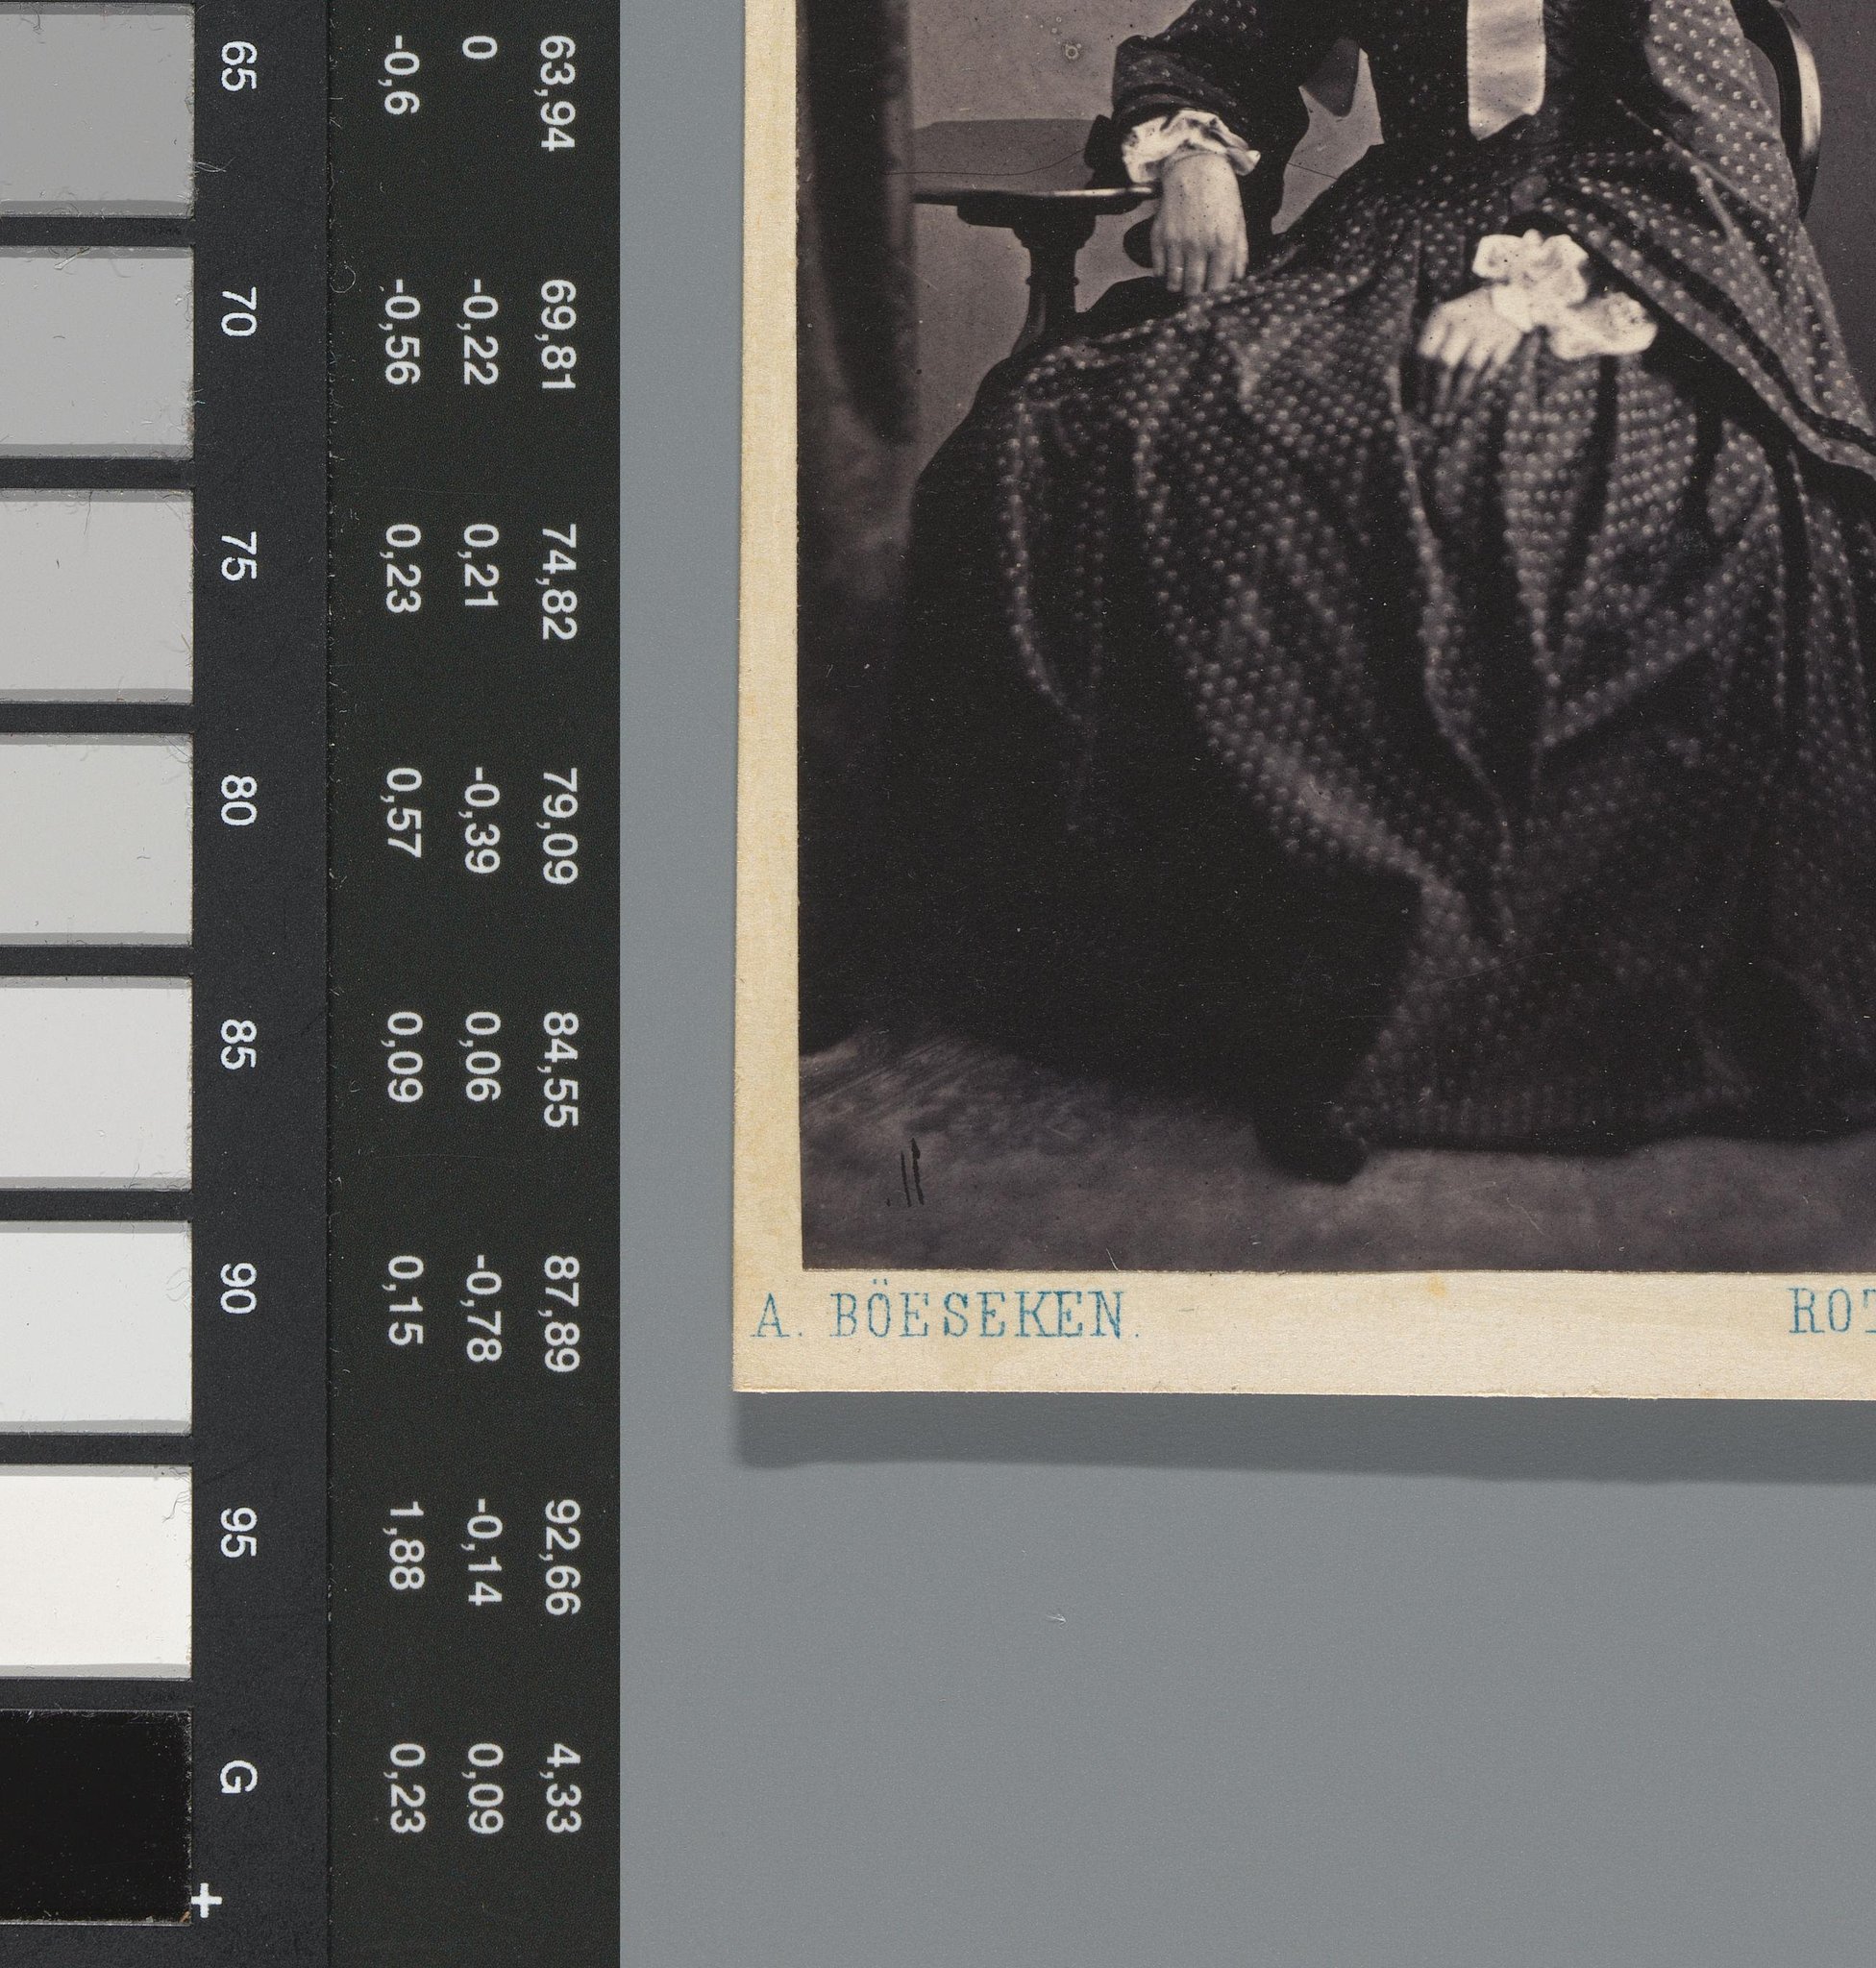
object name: photograph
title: Portret van Emilia Maria Theresia van Kerckhoff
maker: a. böeseken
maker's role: fotograaf, lithograaf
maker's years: 1834-1919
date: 1855-1910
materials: cardboard, photographic support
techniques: albumen print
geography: rotterdam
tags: rotterdam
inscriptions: address: ‘Photographisch Atelier / A. BÖESKEN / Hoogstraat over de Vlasmarkt / ROTTERDAM.’